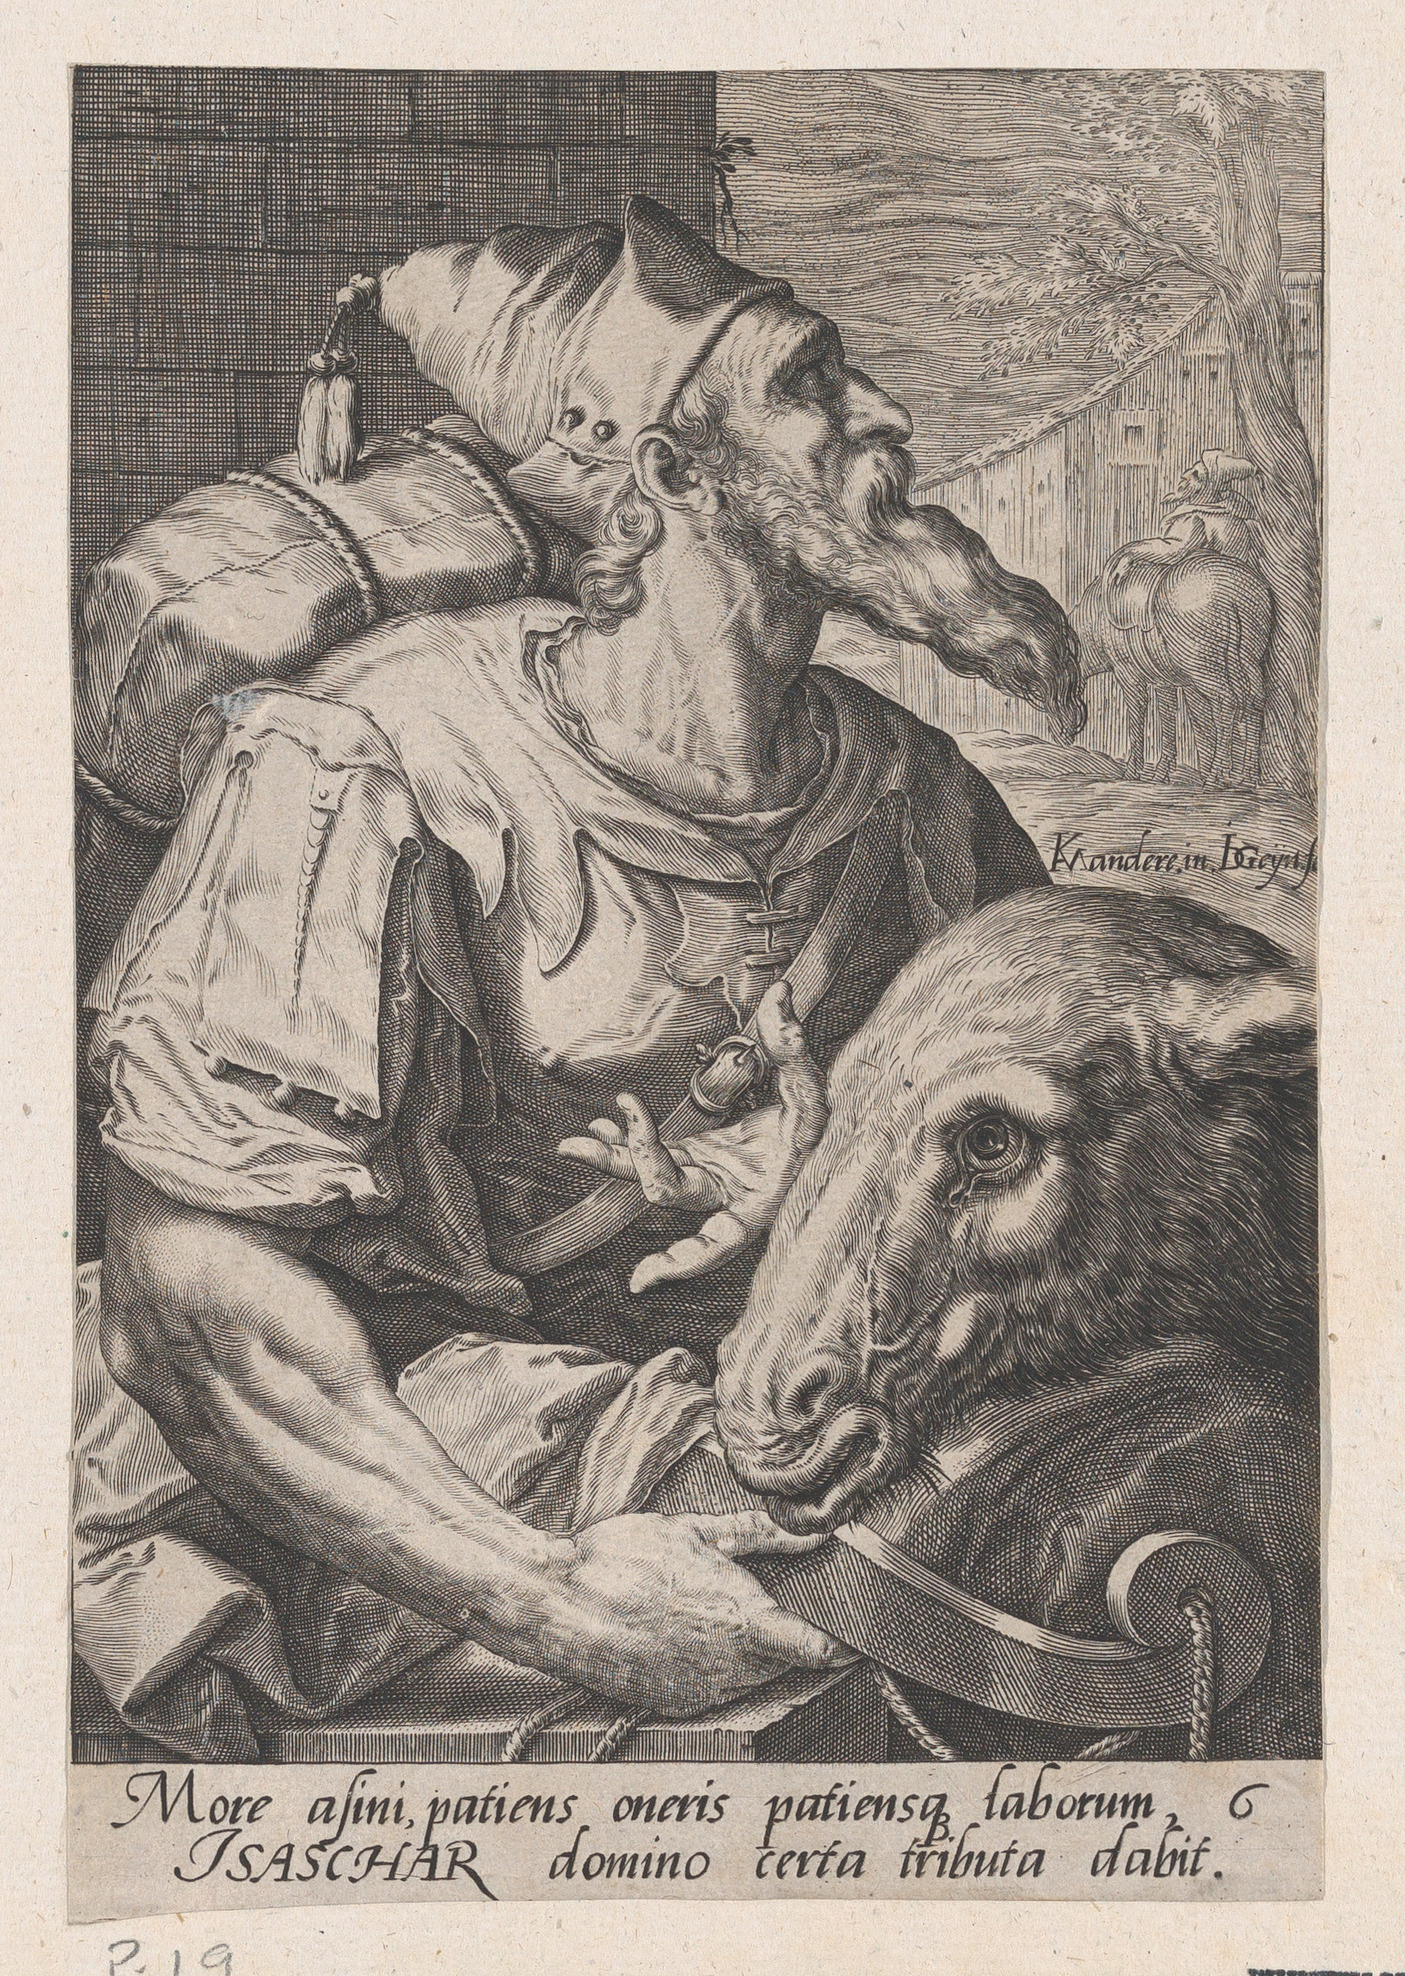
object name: print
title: Issachar, from The Twelve Sons of Jacob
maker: jacques de gheyn (ii)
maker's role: artist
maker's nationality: netherlandish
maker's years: 1565-1629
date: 1584-1594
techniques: engraving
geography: amsterdam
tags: animals,men